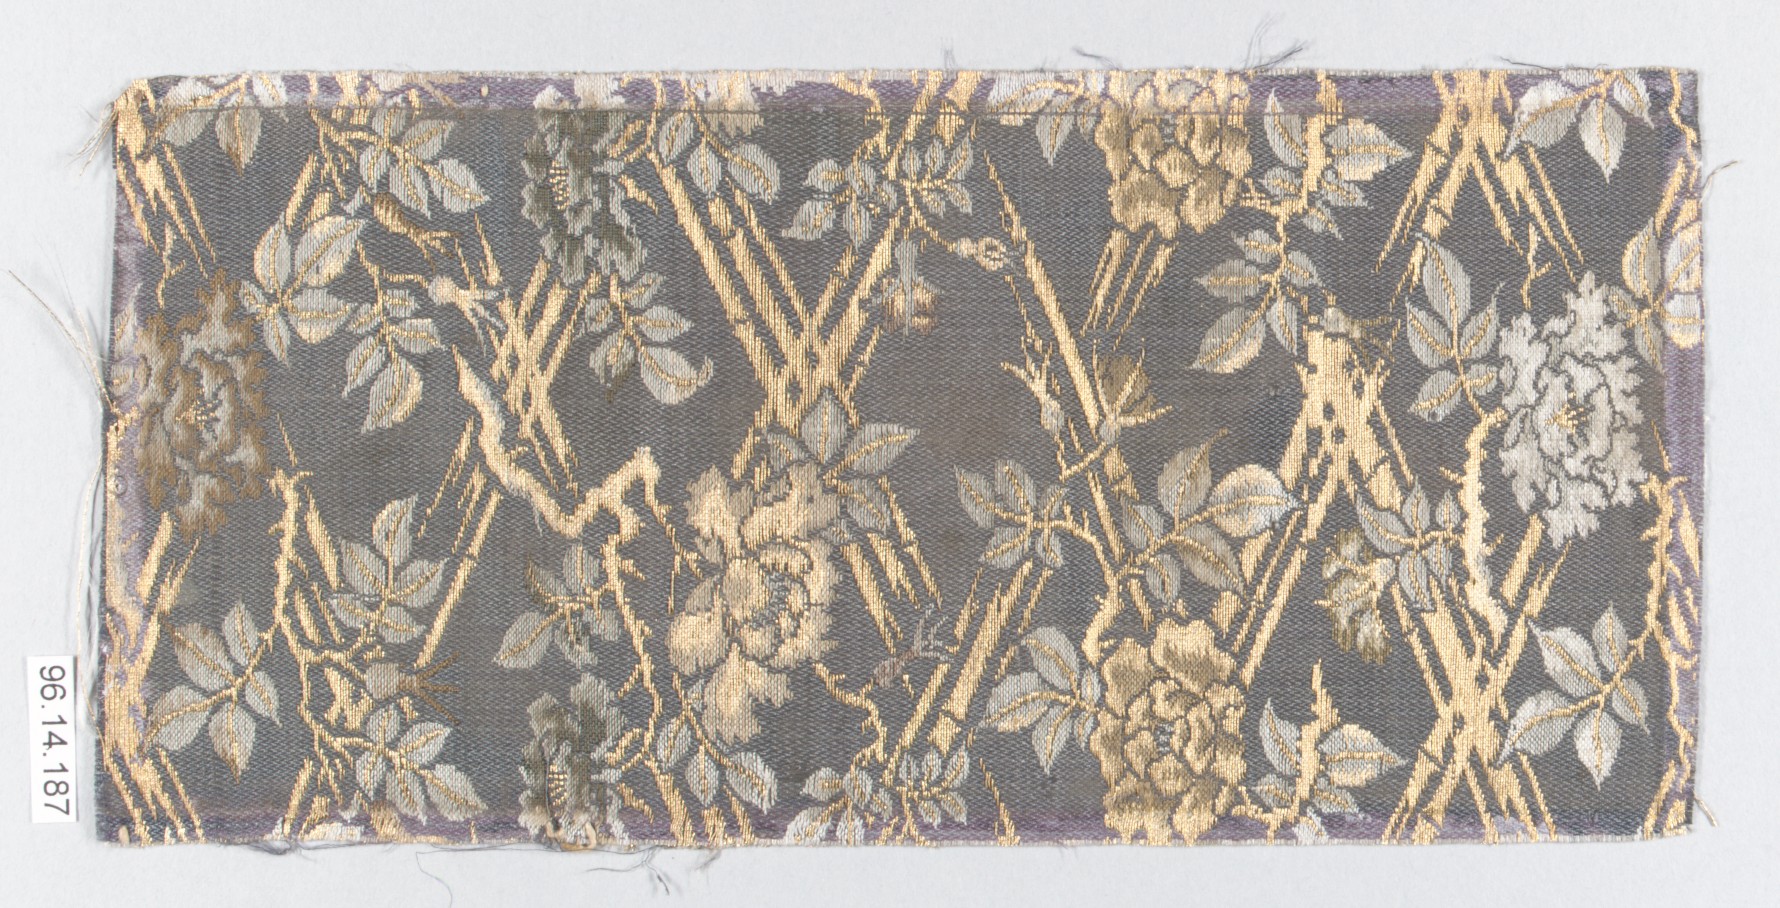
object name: piece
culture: japanese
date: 1767-1800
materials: metal thread, silk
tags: flowers